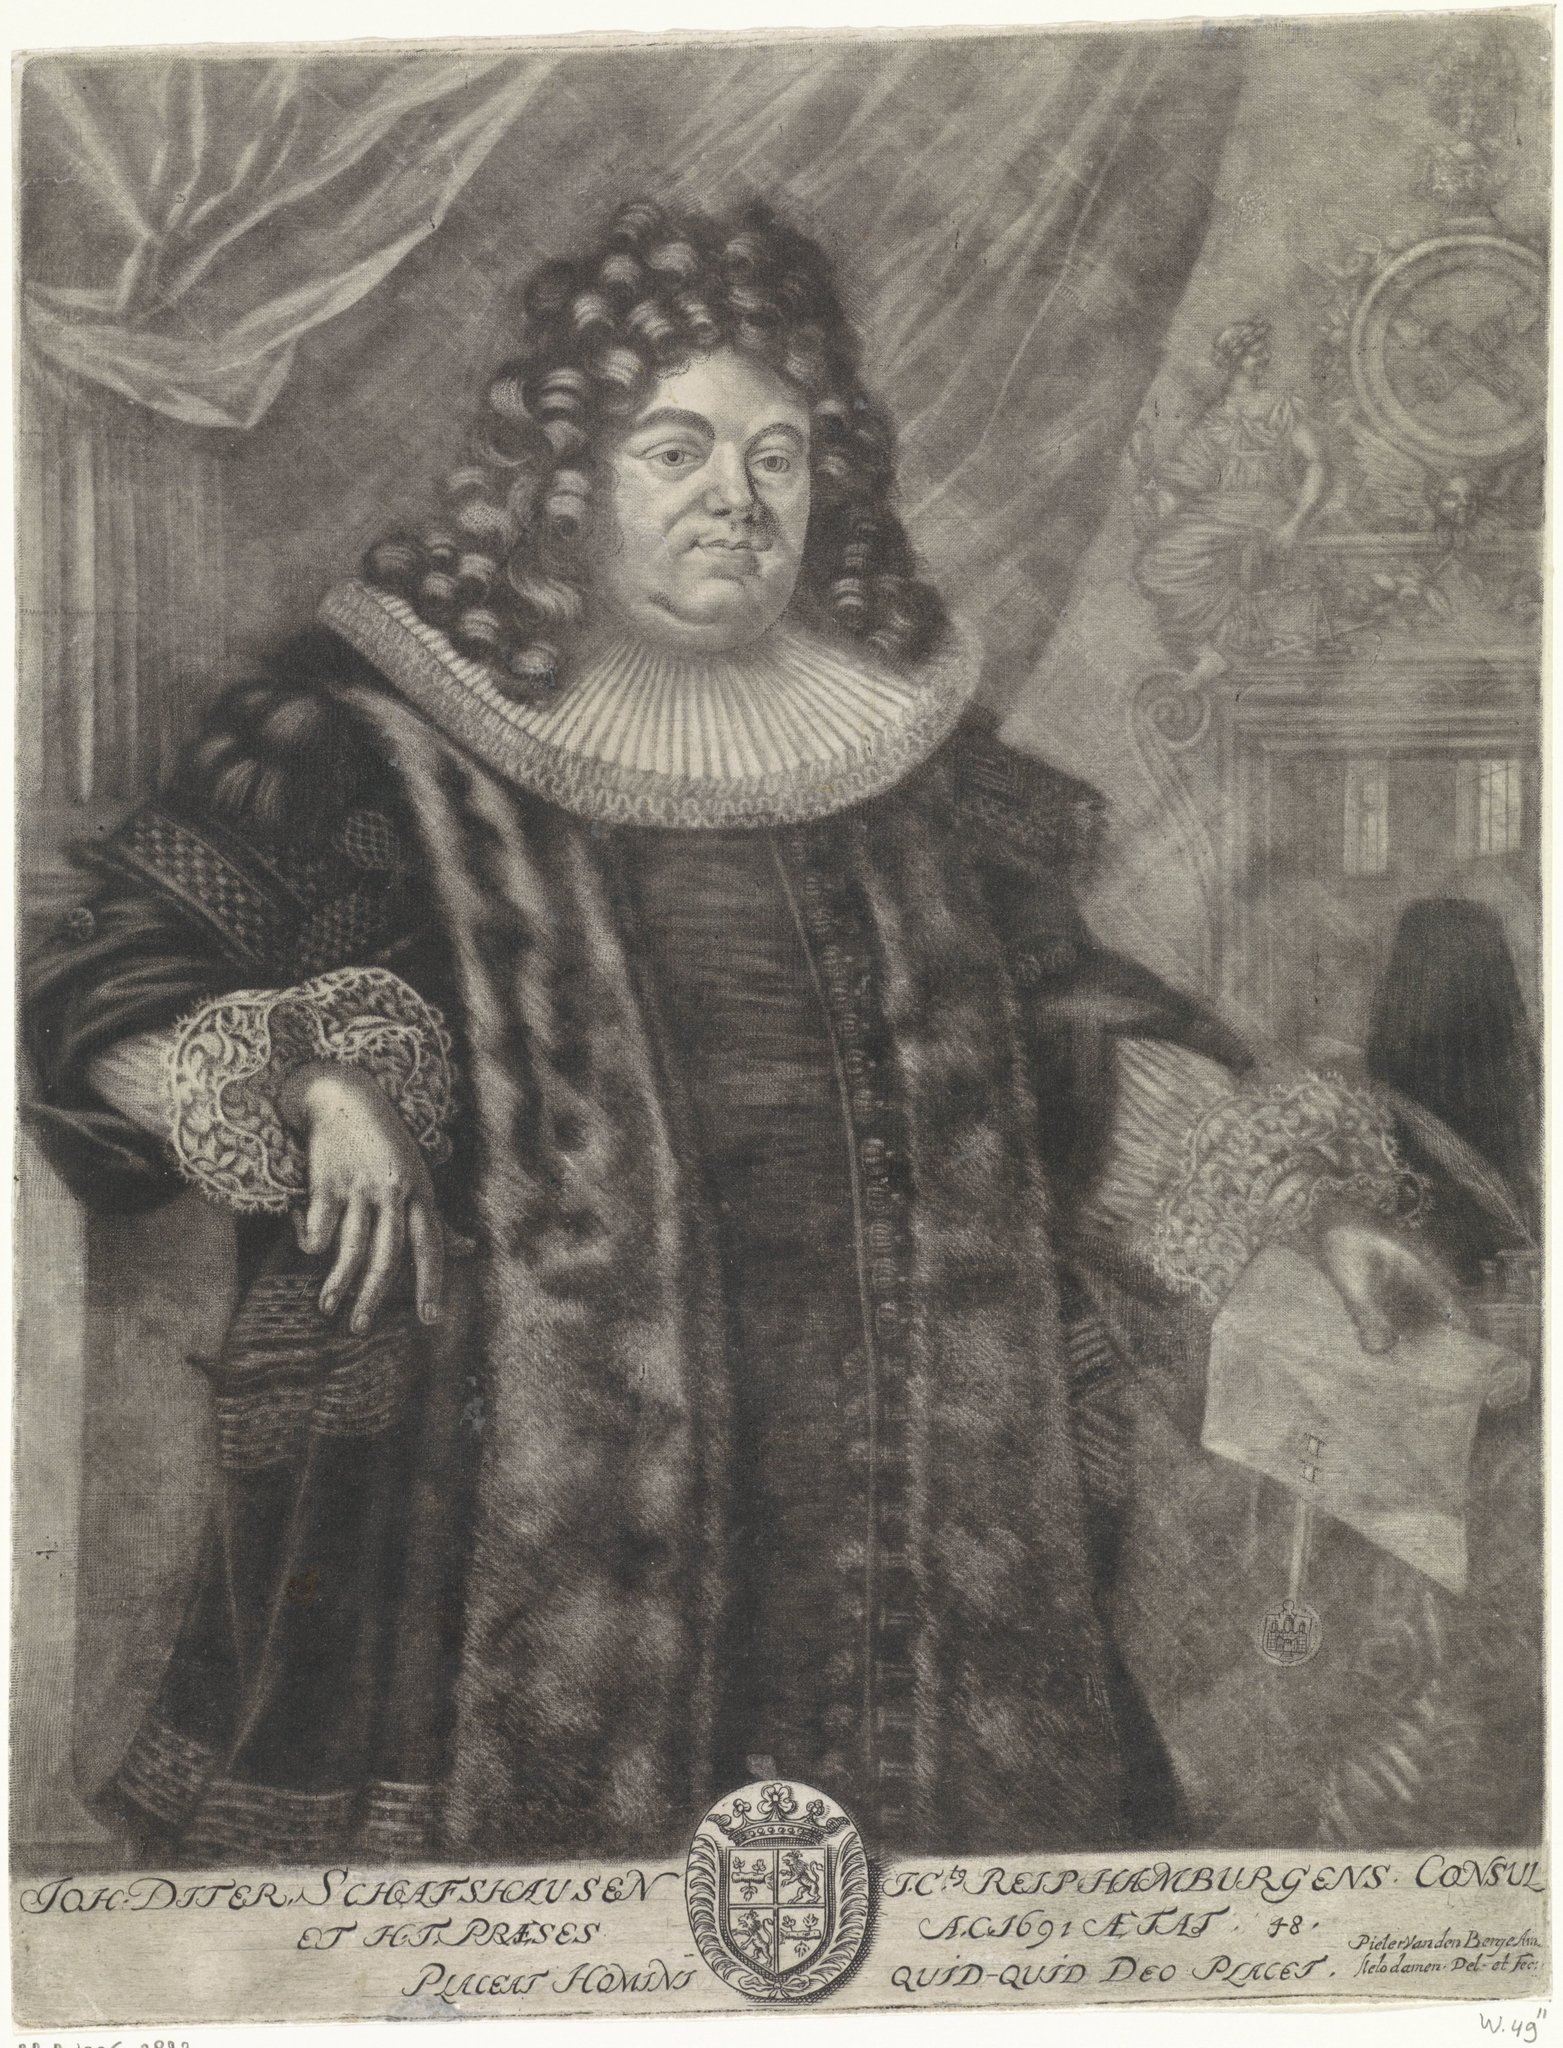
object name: print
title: Portret van Johann Dietrich Schaffhausen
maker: pieter van den berge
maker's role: draughtsman, print maker, printer, publisher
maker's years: 1659-1737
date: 1691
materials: paper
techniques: engraving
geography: hamburg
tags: writing-table, writing-desk, wig, law and jurisprudence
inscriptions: collector's mark: Lugt 2228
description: Portret van Johann Dietrich Schaffhausen op 48-jarige leeftijd. Hij staat bij zijn schrijftafel met in de hand een brief. Op de achtergrond een doorgang waarboven ornamenten en beelden die rechtspraak symboliseren. In de marge zijn naam, titels, leeftijd en een wapenschild.